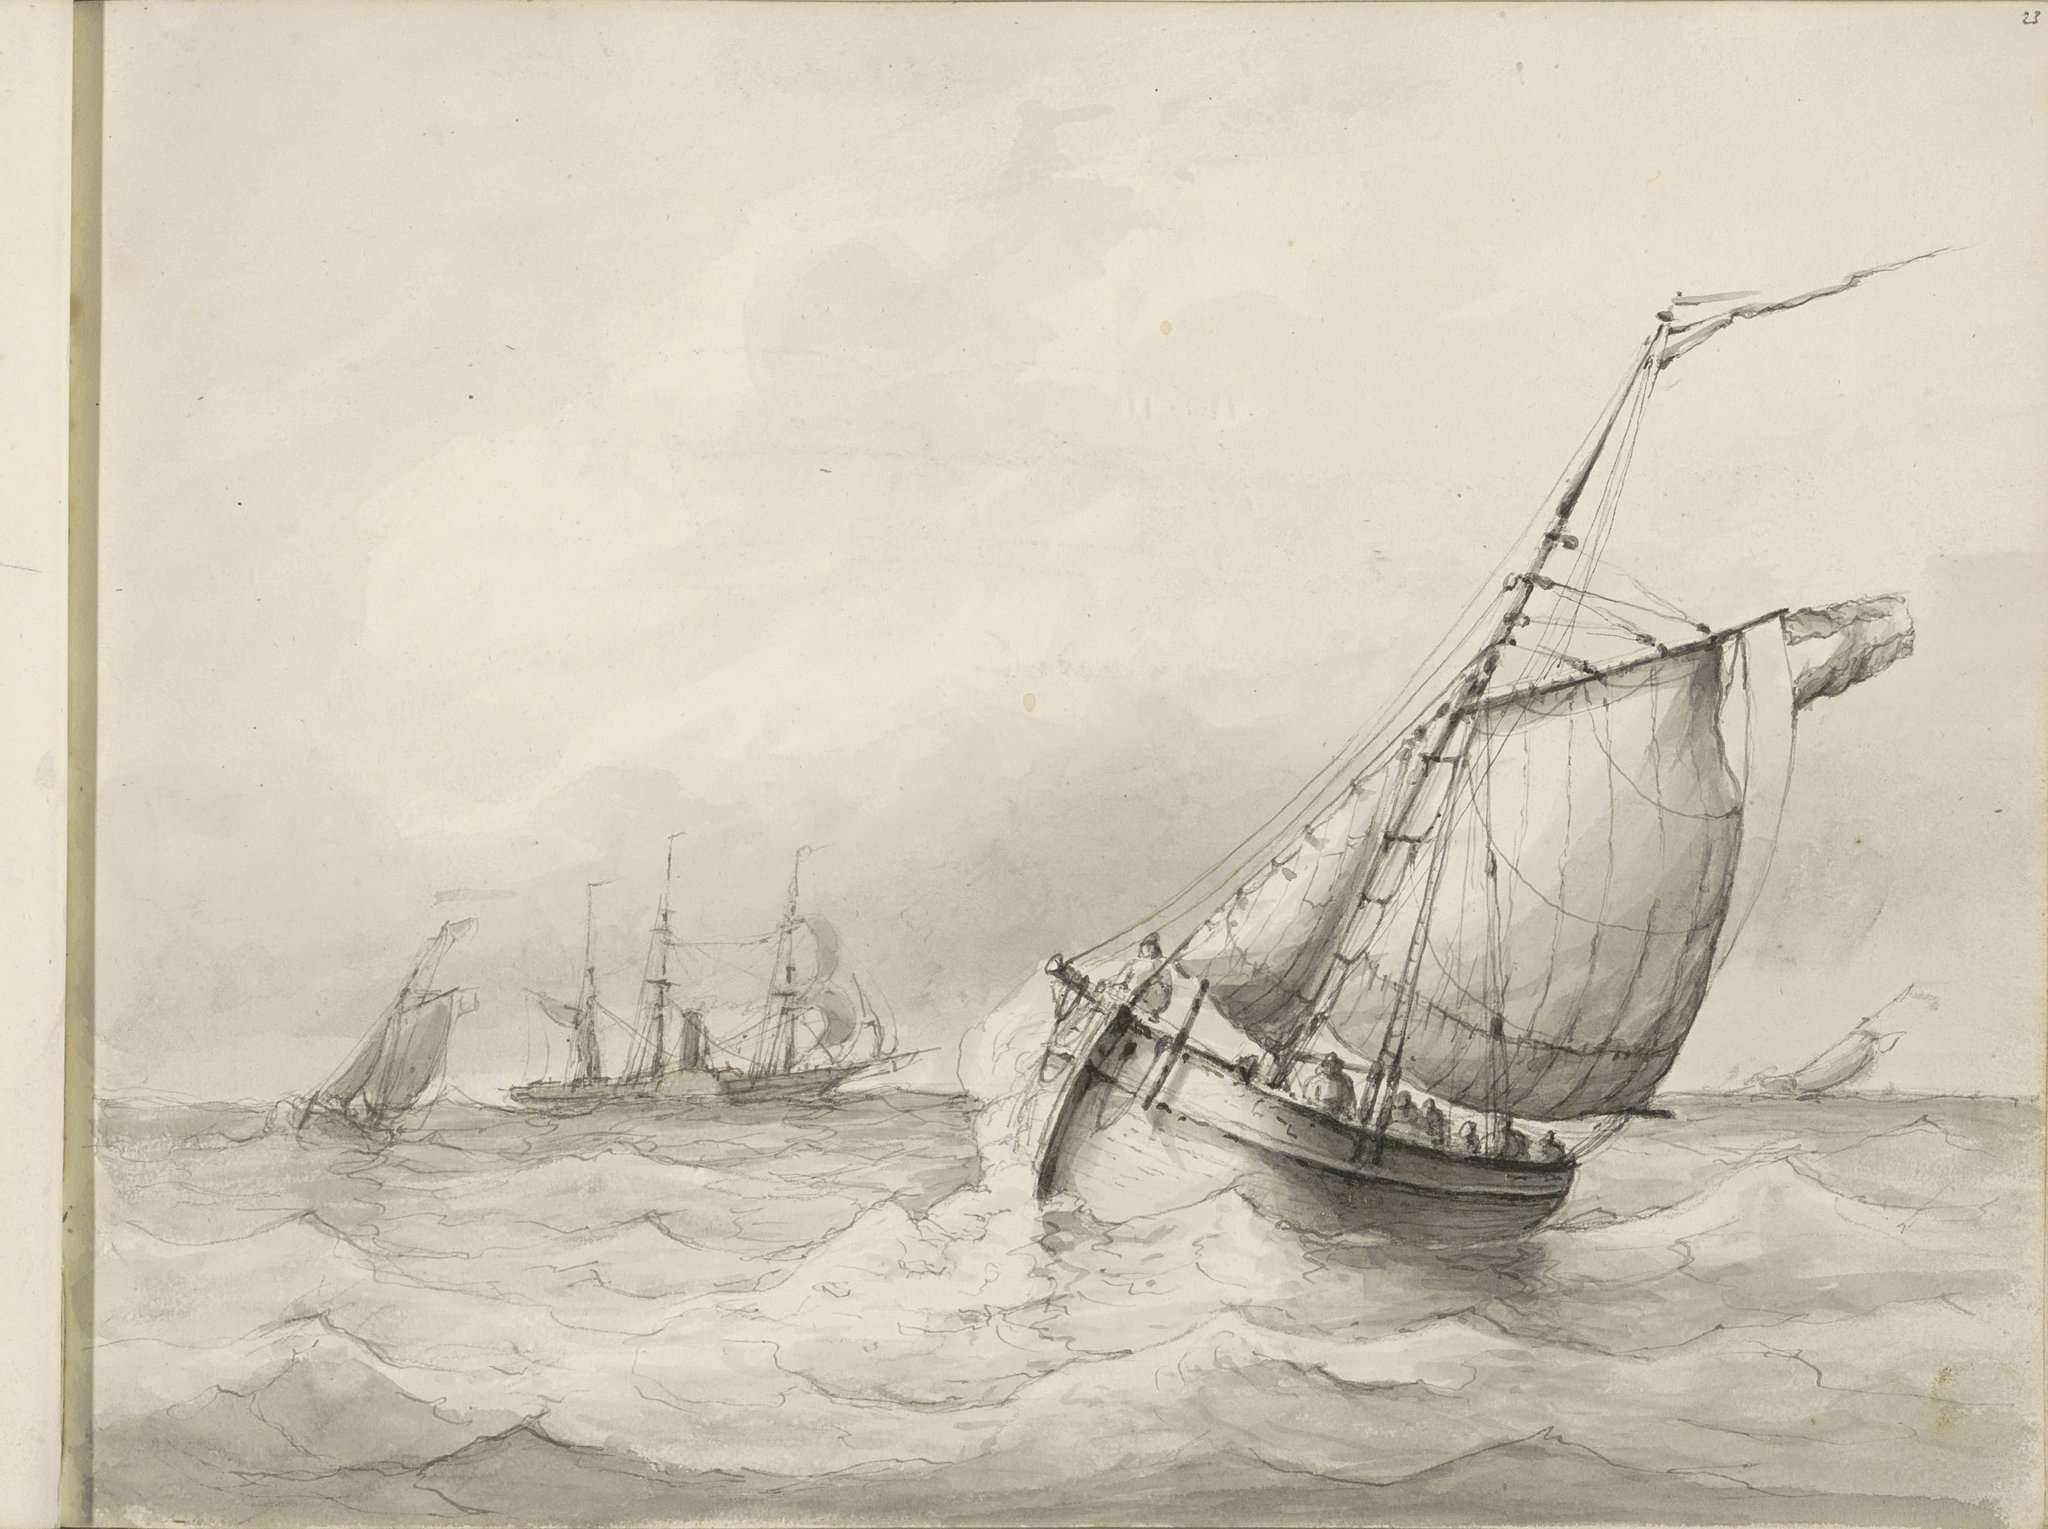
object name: sketchbook leaf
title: Zeilschepen op zee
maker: petrus johannes schotel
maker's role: draughtsman, painter, print maker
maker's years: 1808-1865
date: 1825-1875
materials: ink, paper, pencil, watercolor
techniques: brush, pen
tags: sea (seascape)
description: Blad 23 recto uit een schetsboek met 44 bladen.